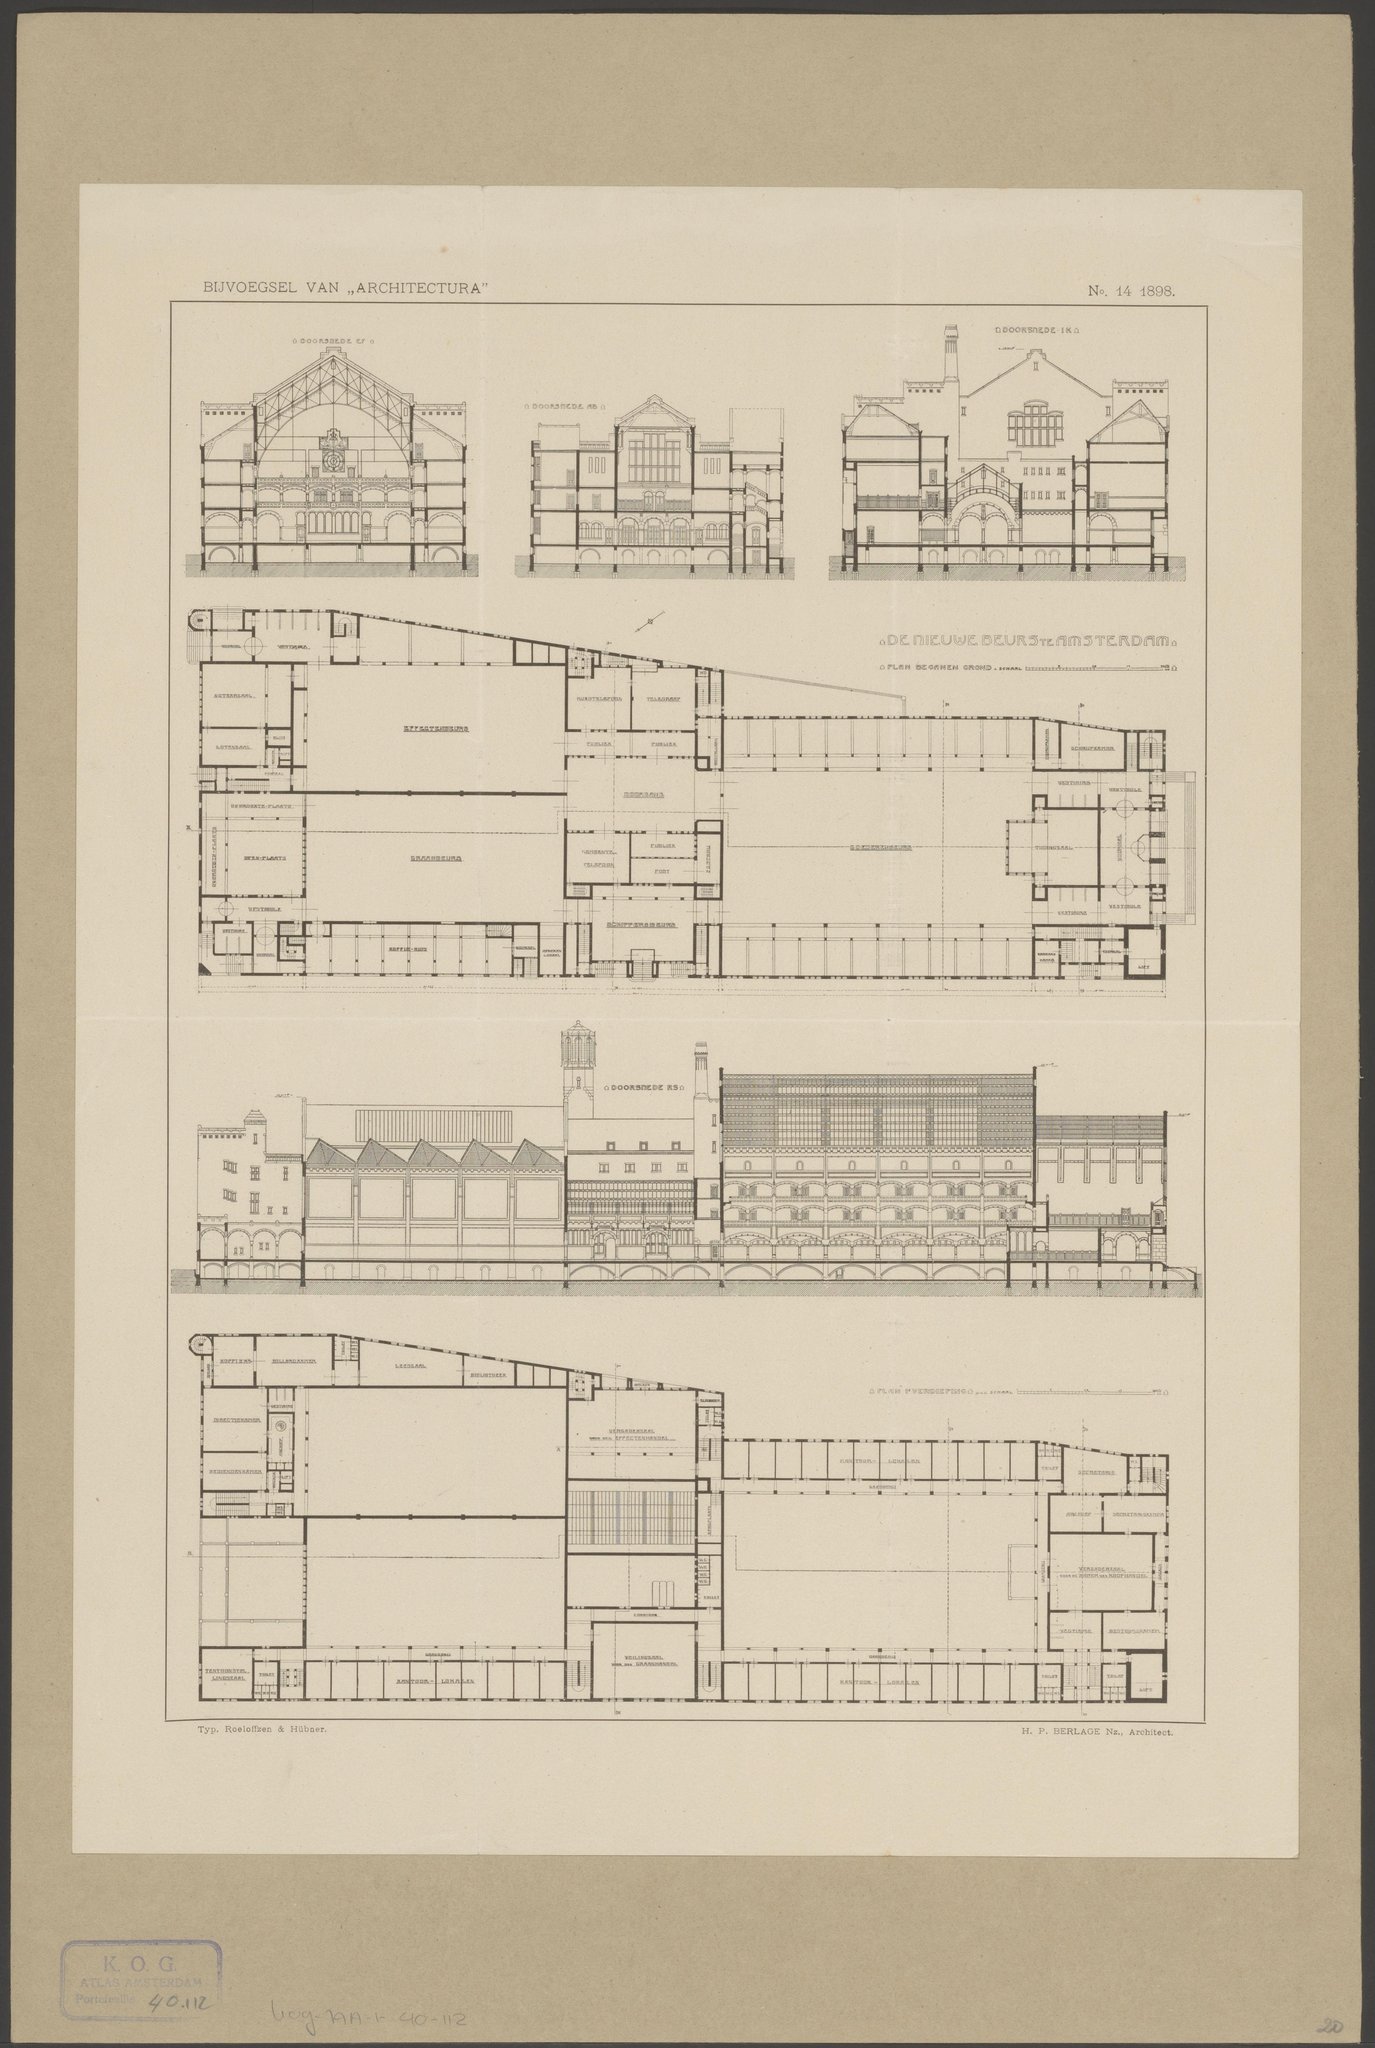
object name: photomechanical print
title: Doorsnedes en plattegronden van de Nieuwe Beurs in Amsterdam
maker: hendrik petrus berlage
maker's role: draughtsman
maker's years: 1856-1934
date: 1898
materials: paper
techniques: line block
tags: stock exchange, stock-market, amsterdam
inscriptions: collector's mark: Lugt 1641b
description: Onderwerpsrubriek binnen de Atlas Amsterdam: Handel en Zeevaart, D. Beurs-Ontwerpen.